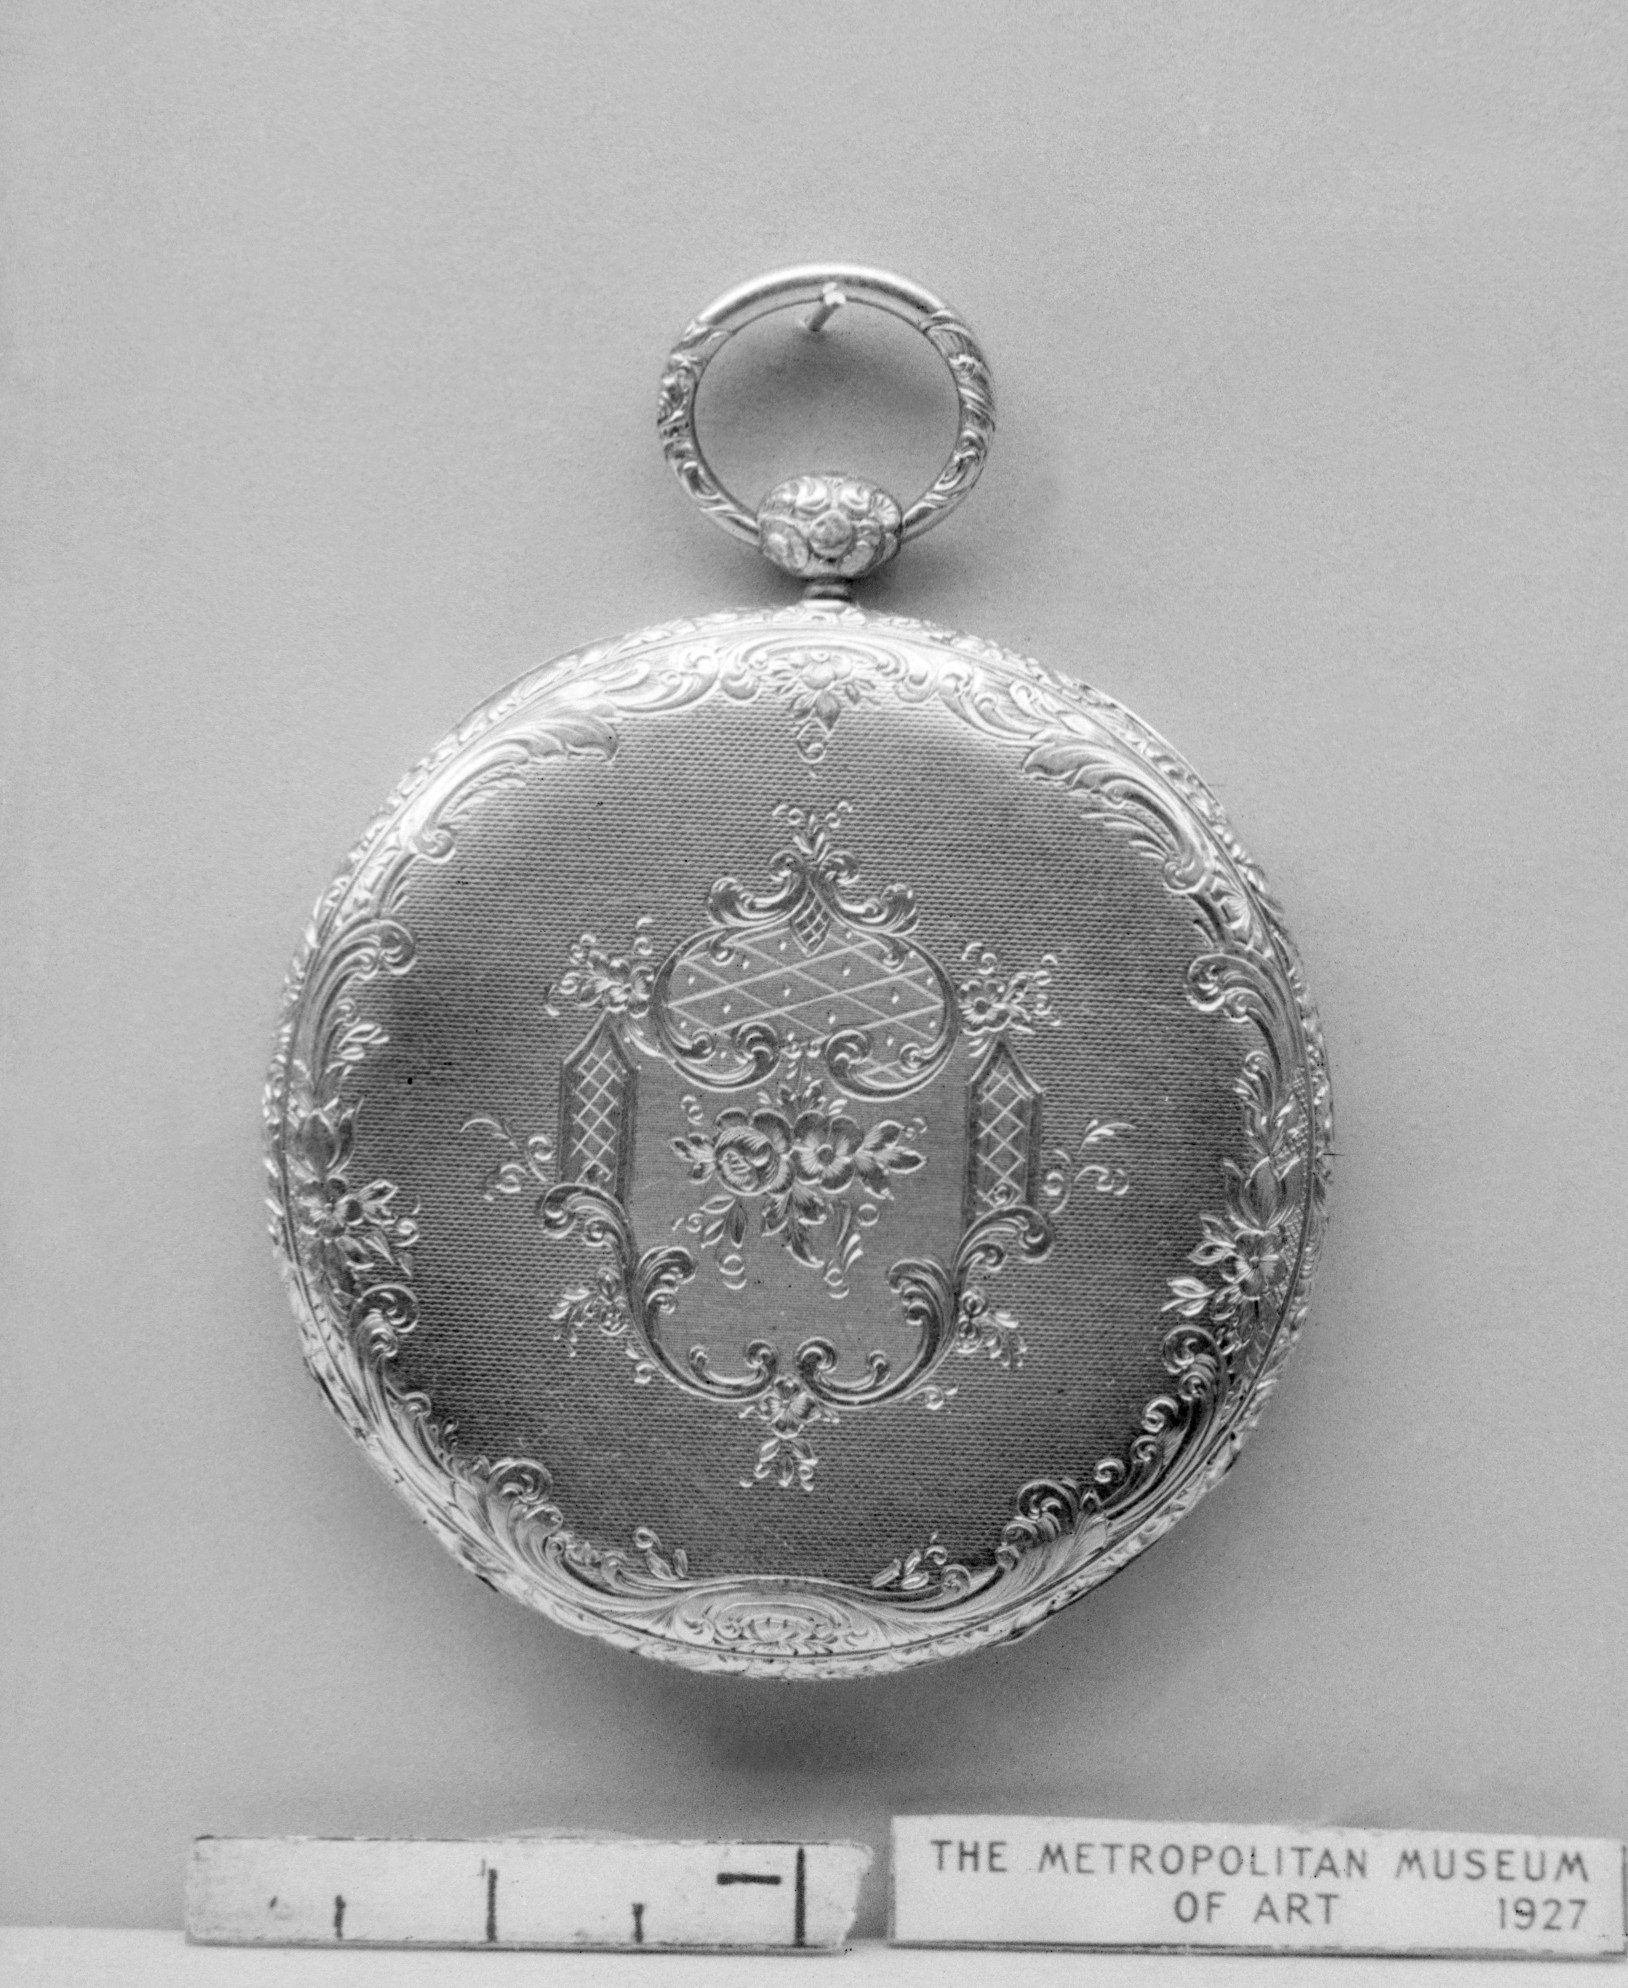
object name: watch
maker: enar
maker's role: maker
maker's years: 1800-1900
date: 1840-1850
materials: enamel, gold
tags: leaves